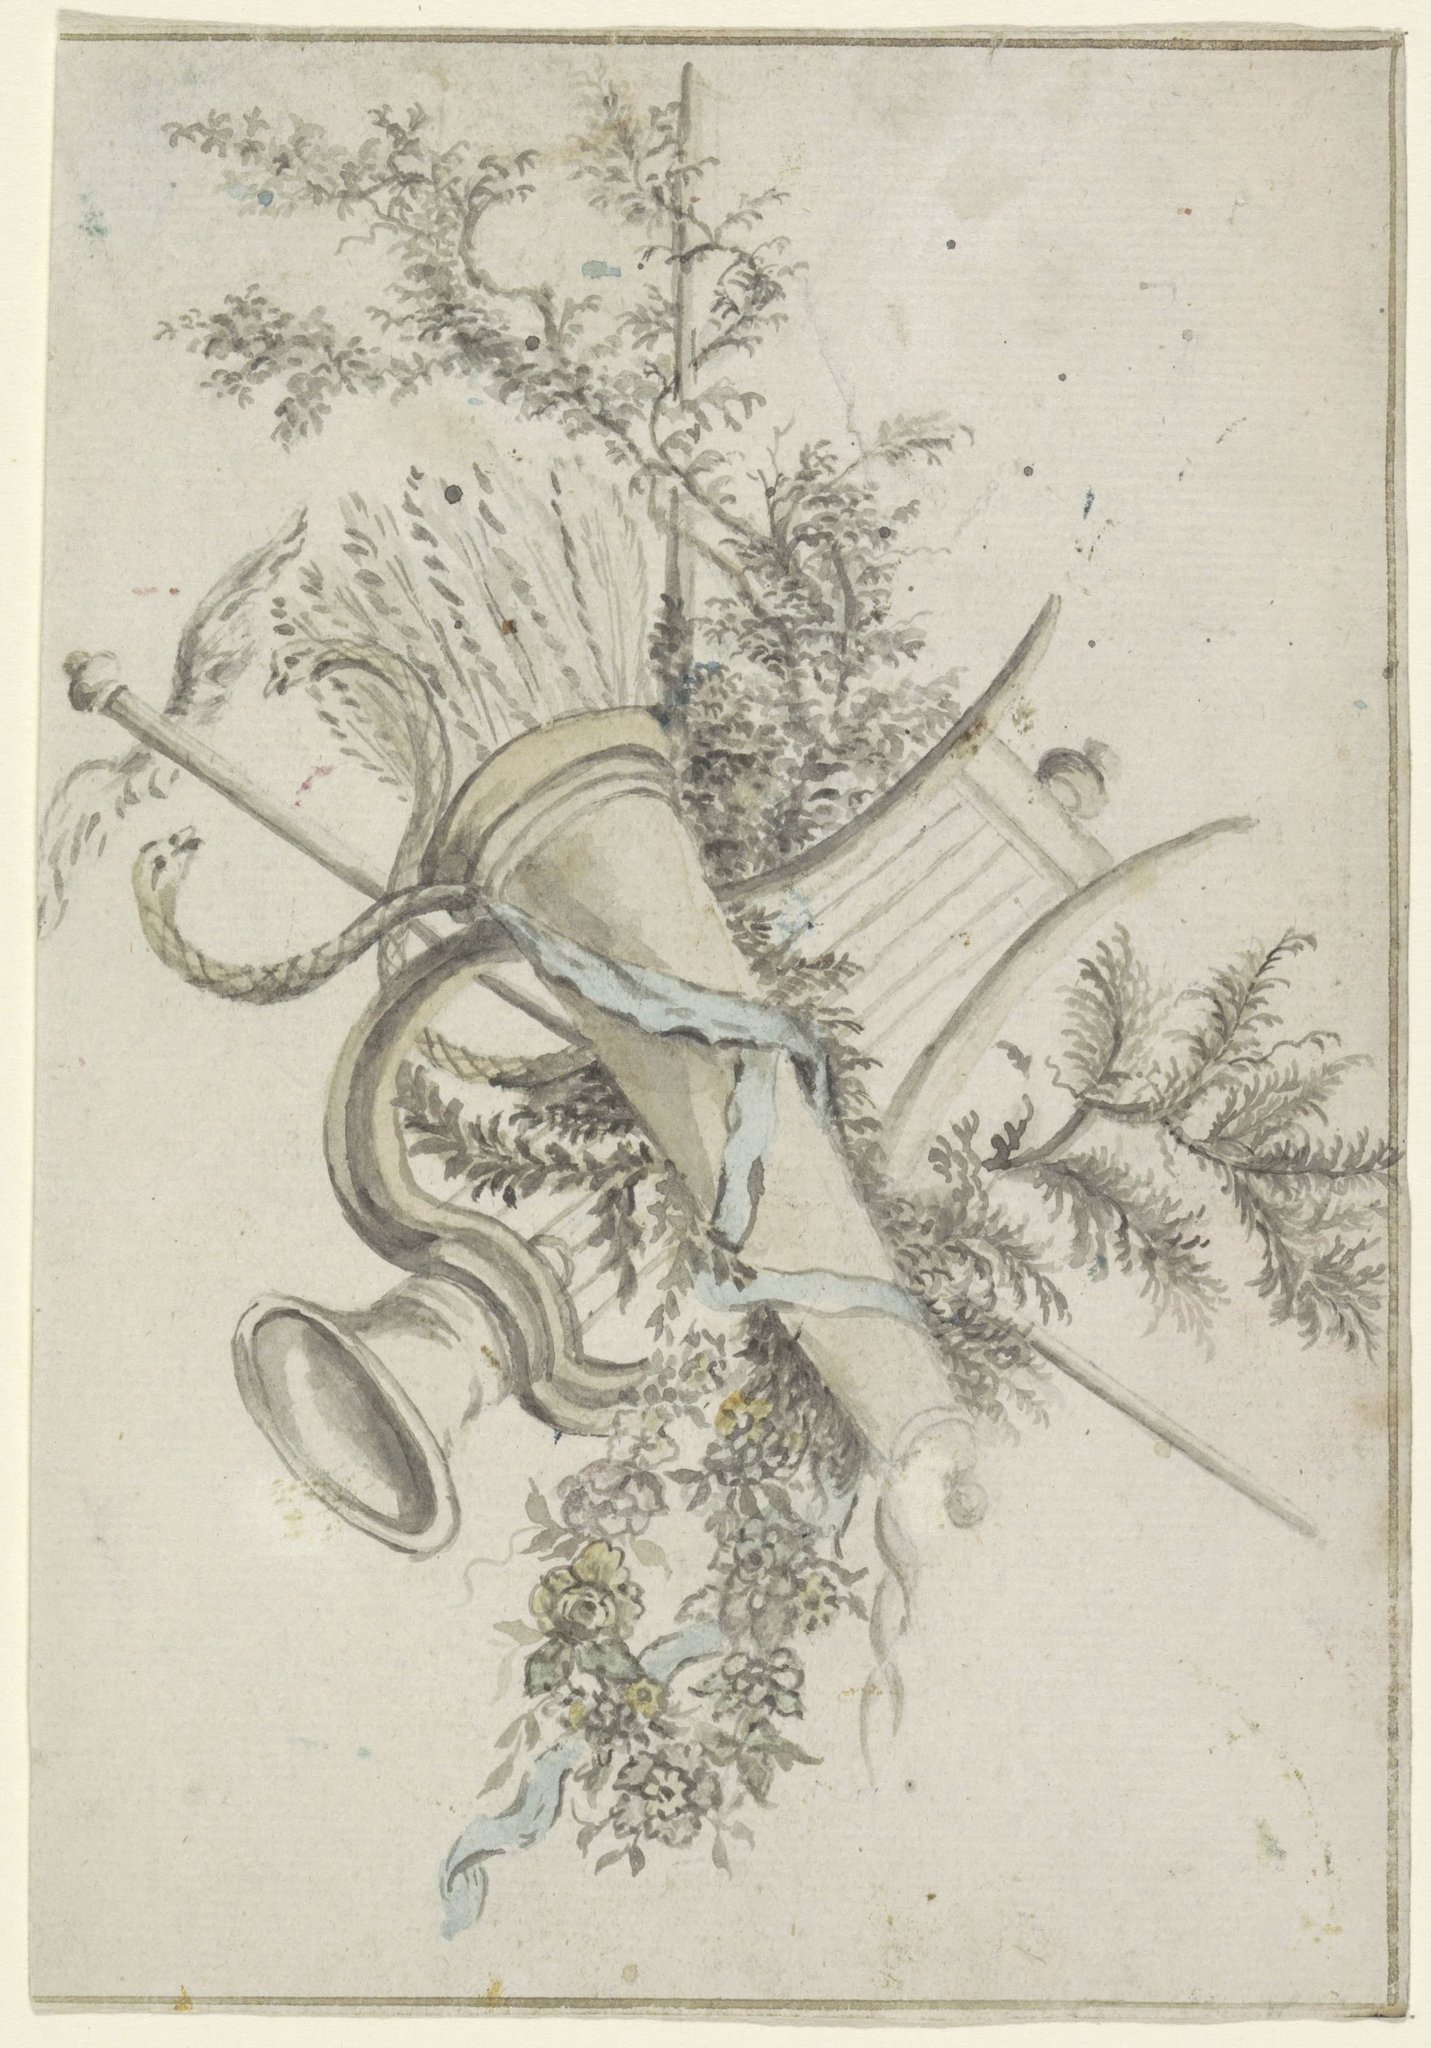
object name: drawing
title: Trofee met godenattributen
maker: Anonymous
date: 1700-1800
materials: ink, paper, watercolor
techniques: brush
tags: trophy, i.e.: decorative arrangement of symbolic or typical objects ~ ornament, gods ~ classical mythology (+ attributes)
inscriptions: collector's mark: Lugt 2228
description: Een trofee met takken, een bloemguirlande en godenattributen zoals een caduceus, een pijlenkoker en een lier.